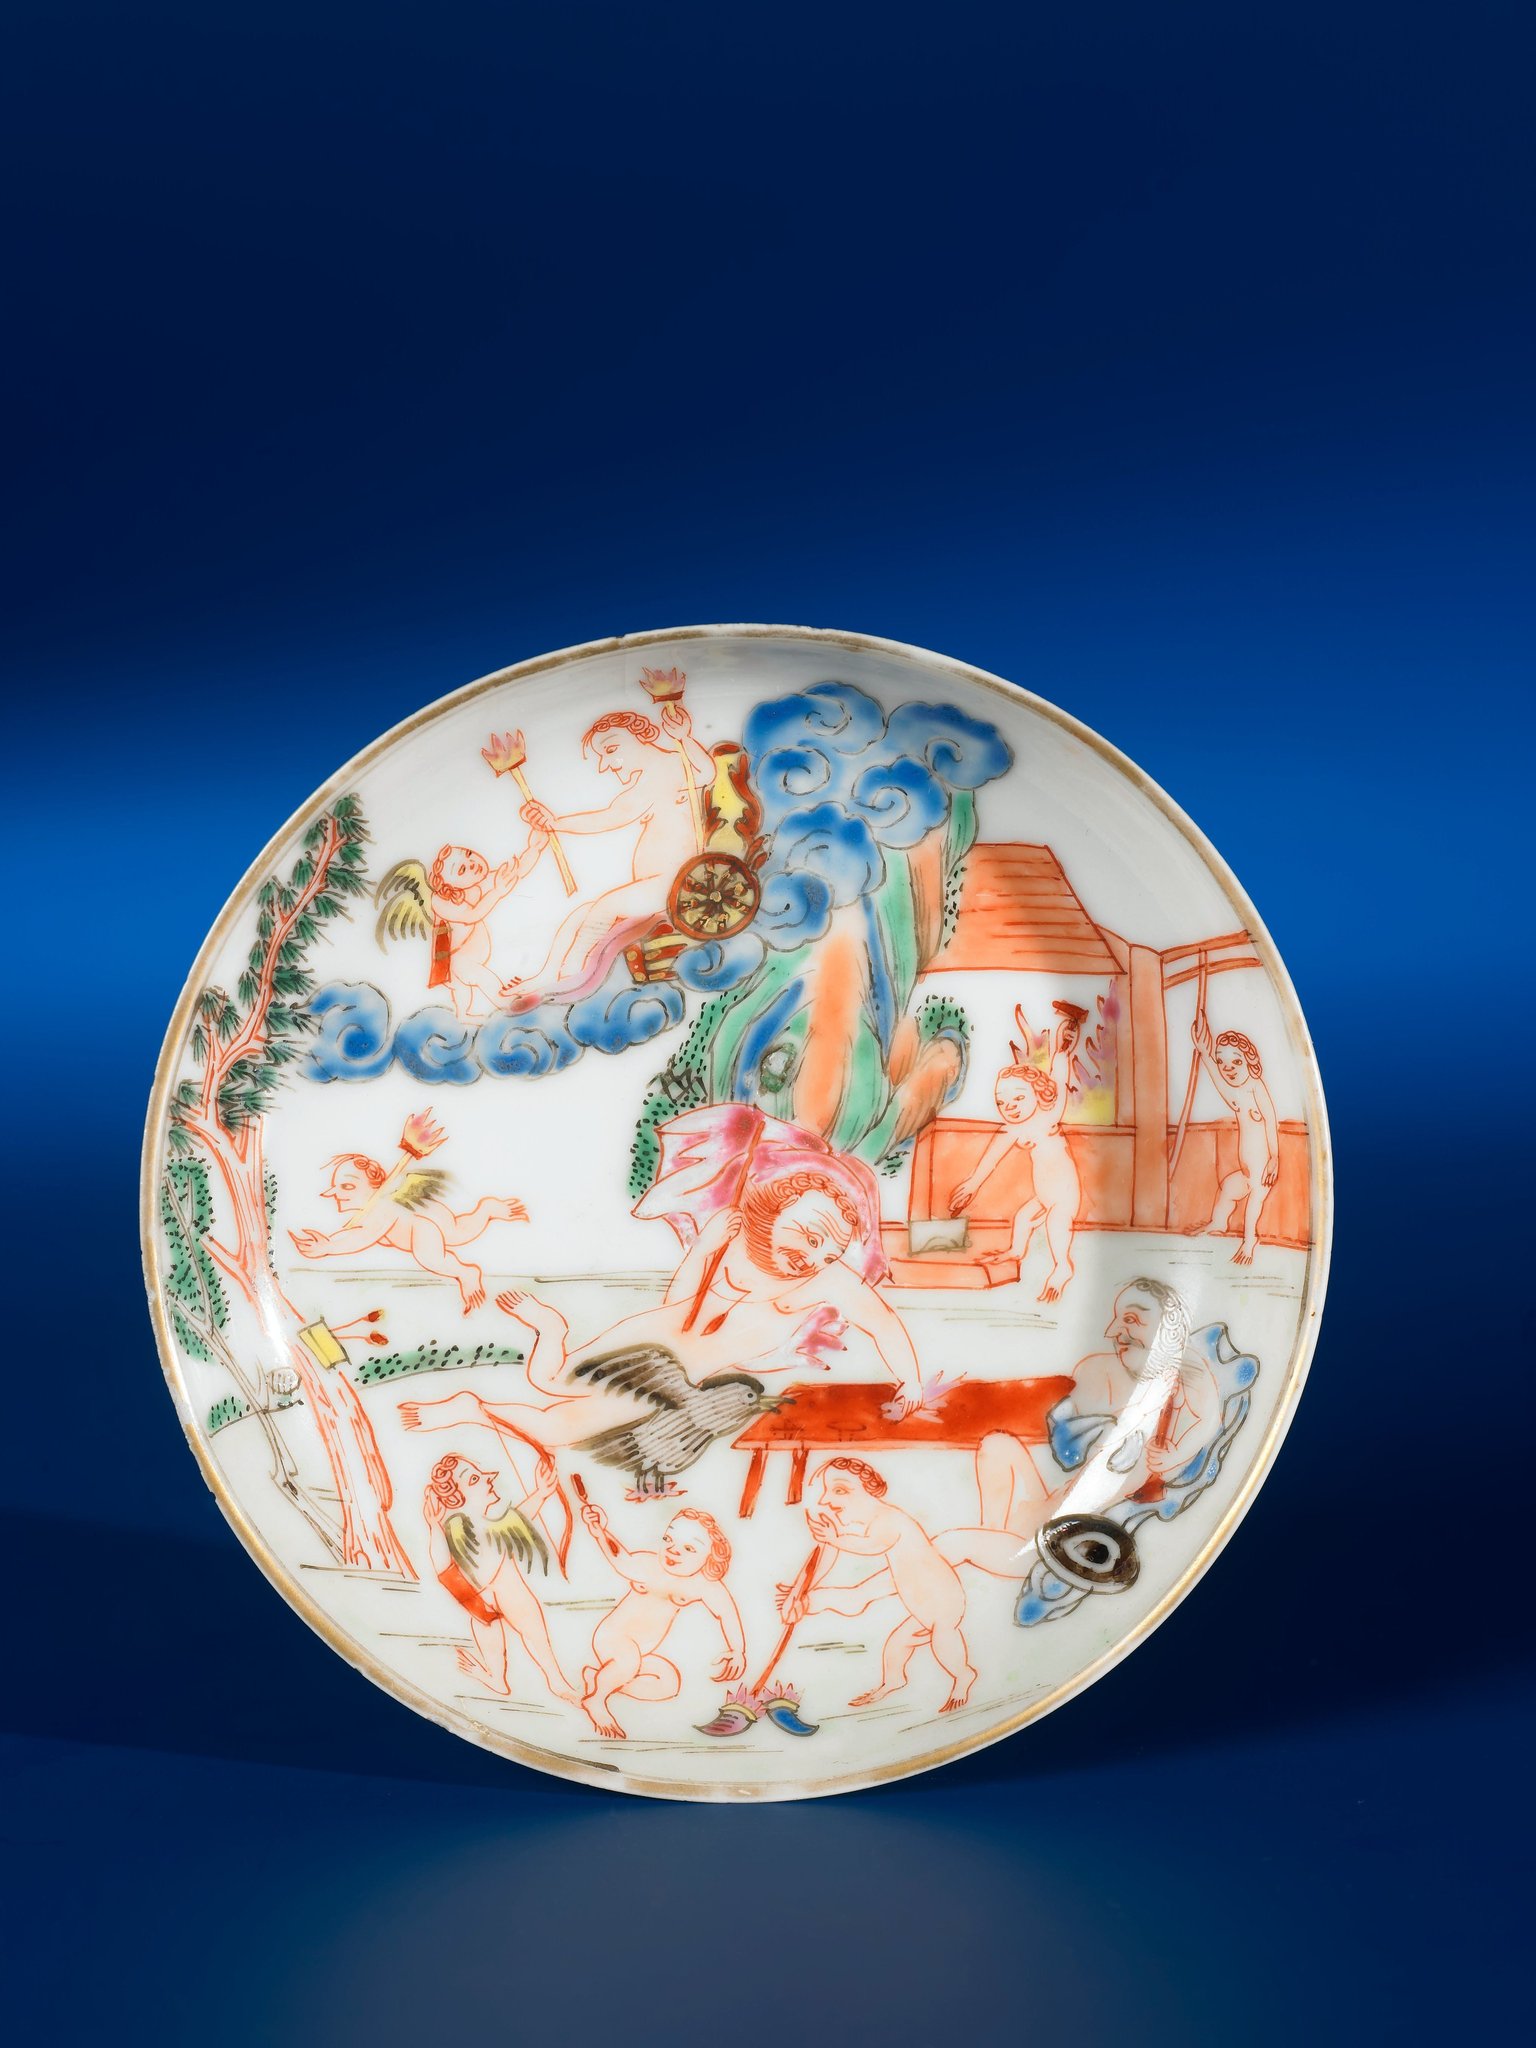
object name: platter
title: Saucer with a mythological image based on the element Fire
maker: Anonymous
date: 1740-1760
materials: glaze, gold, paint, porcelain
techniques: firing, gilding, turning, vitrification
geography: paris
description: Bord op een voetring. Gedecoreerd in emailkleuren en goud met een allegorische voorstelling van het element Vuur. In het midden van de voorstelling is Jupiter te zien, god van het licht en de (stralende) hemel en alle natuurverschijnselen. Rechts afgebeeld is Vulcanus, god van het vuur en het smidswerk. In de wolken in een wagen zit Venus, de godin van de liefde. Rondom verschillende Amors, zij symboliseren de kracht die staal en diamant kunnen doorboren, en zelfs de harten van de goden. De voorstelling is bijzonder amateuristisch geschilderd. De prent die als voorbeeld diende werd gemaakt door Antoine Herisset (1685-1769) naar een schilderij van Francesco Albani (1578-1669). De voorstelling is uit een serie van vier, de andere elementen zijn Water, Lucht en Aarde. Alle elementen zijn uitgebeeld door dezelfde kunstenaars, op schilderij en op prent. Al deze voorstellingen komen voor op porselein.